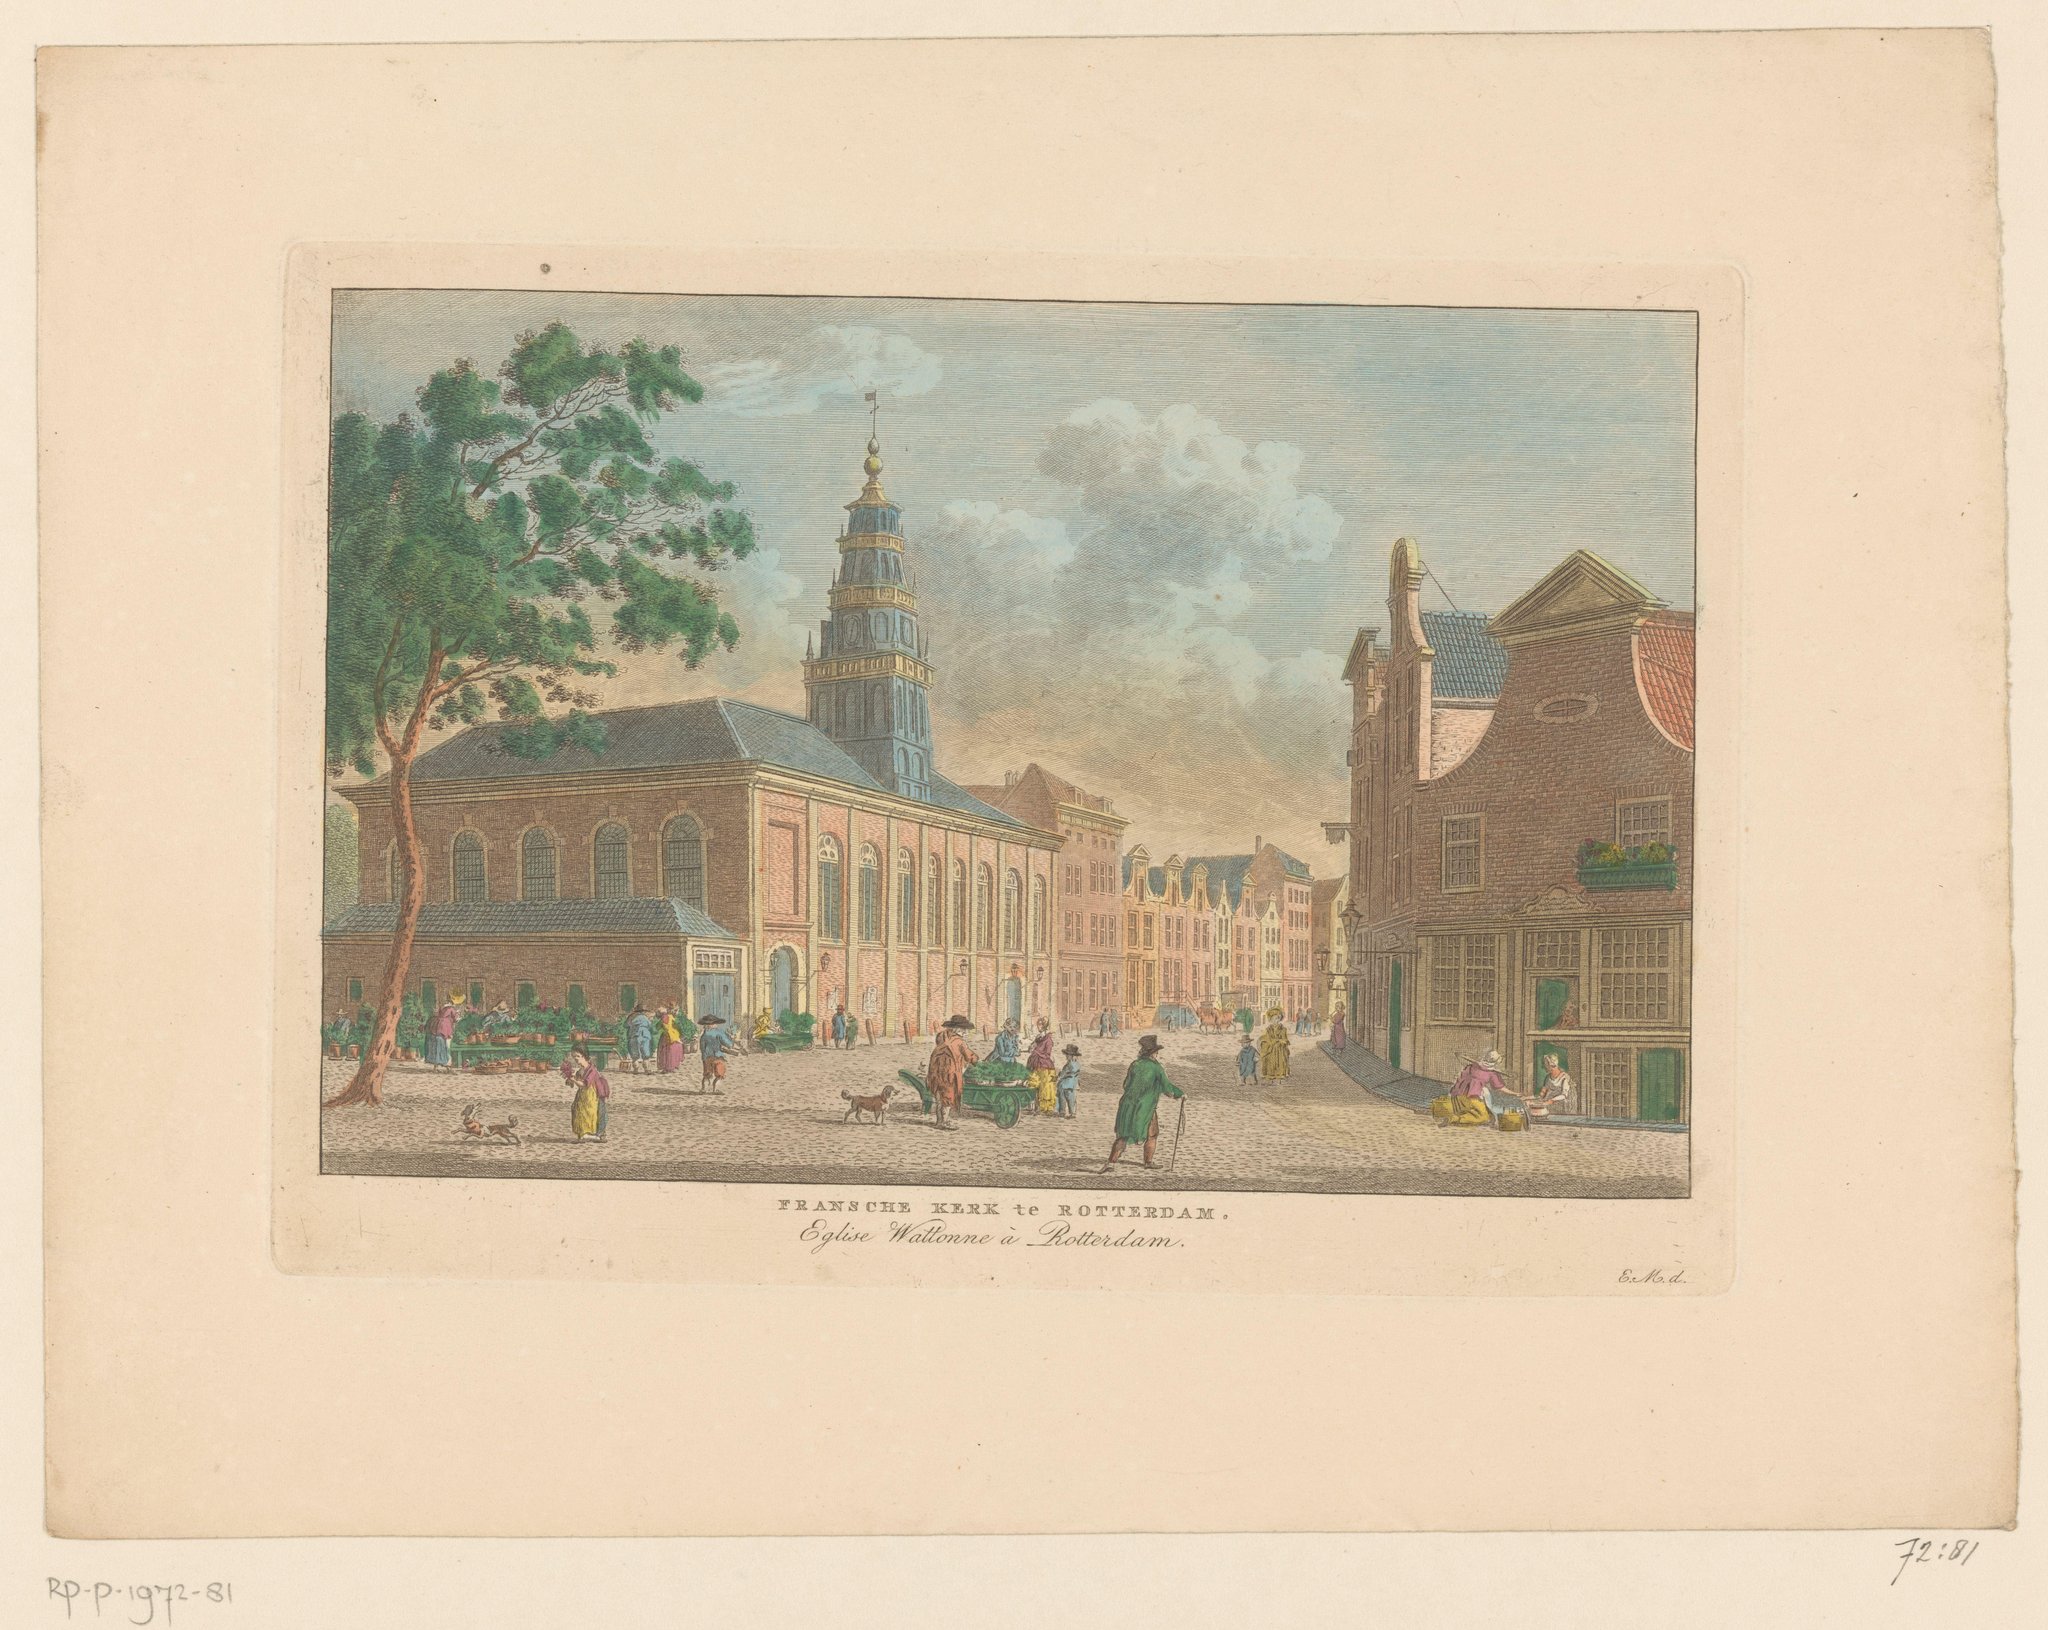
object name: print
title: Fransche kerk te Rotterdam / Eglise Wallonne à Rotterdam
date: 1786-1792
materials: paper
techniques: engraving, etching, hand coloring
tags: church (exterior)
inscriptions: collector's mark: Lugt 2228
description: Huidige staat van prent uitgegeven als onderdeel van een plaatwerk uit ca. 1824-1825 met 74 (ongenummerde) platen van de belangrijkste topografische gezichten en verschillende zeden en gewoonten in het Verenigd Koninkrijk der Nederlanden, getiteld 'Tableau des principales vues des palais et édifices : représentations et des coutumes et usages, dans les provinces septentrionales du Royaume des Pays-Bas'. Eerdere staat gebruikt in: Vaderlandsche gezichten, of afbeeldingen van den tegenwoordigen staat der Vereenigde Nederlanden (…). Amsterdam: Hendrik Gartman, Willem Vermandel en Jan Willem Smit, 1786-1792. Uitgegeven in afleveringen met ieder een eigen bifolium en inhoudsopgave. Alle prenten in deze publicatie zijn gegraveerd door Carel Frederik Bendorp (I) en, in de meeste gevallen, gebaseerd op tekeningen van Jan Bulthuis.